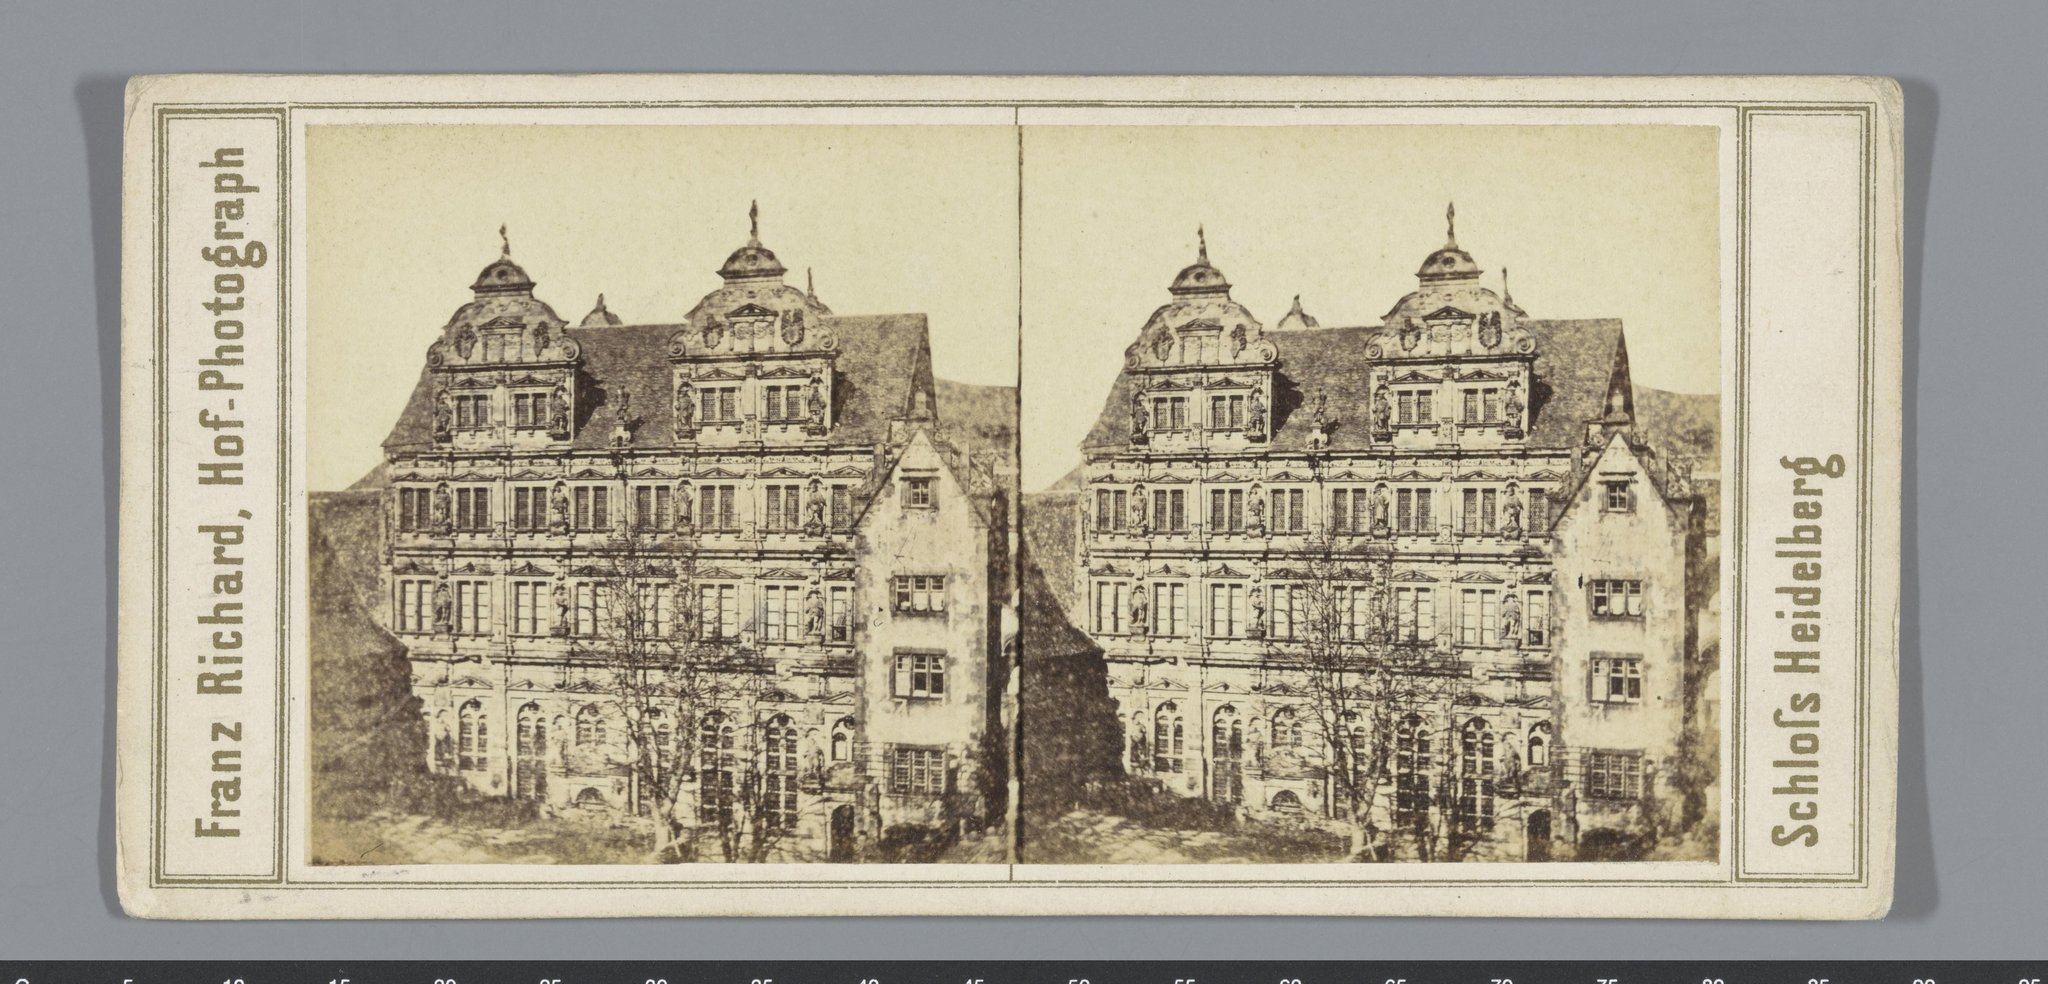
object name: stereograph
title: Schloss Heidelberg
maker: franz richard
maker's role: fotograaf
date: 1860-1880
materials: cardboard, photographic support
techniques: albumen print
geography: heidelberg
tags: castle, façade (of house or building)